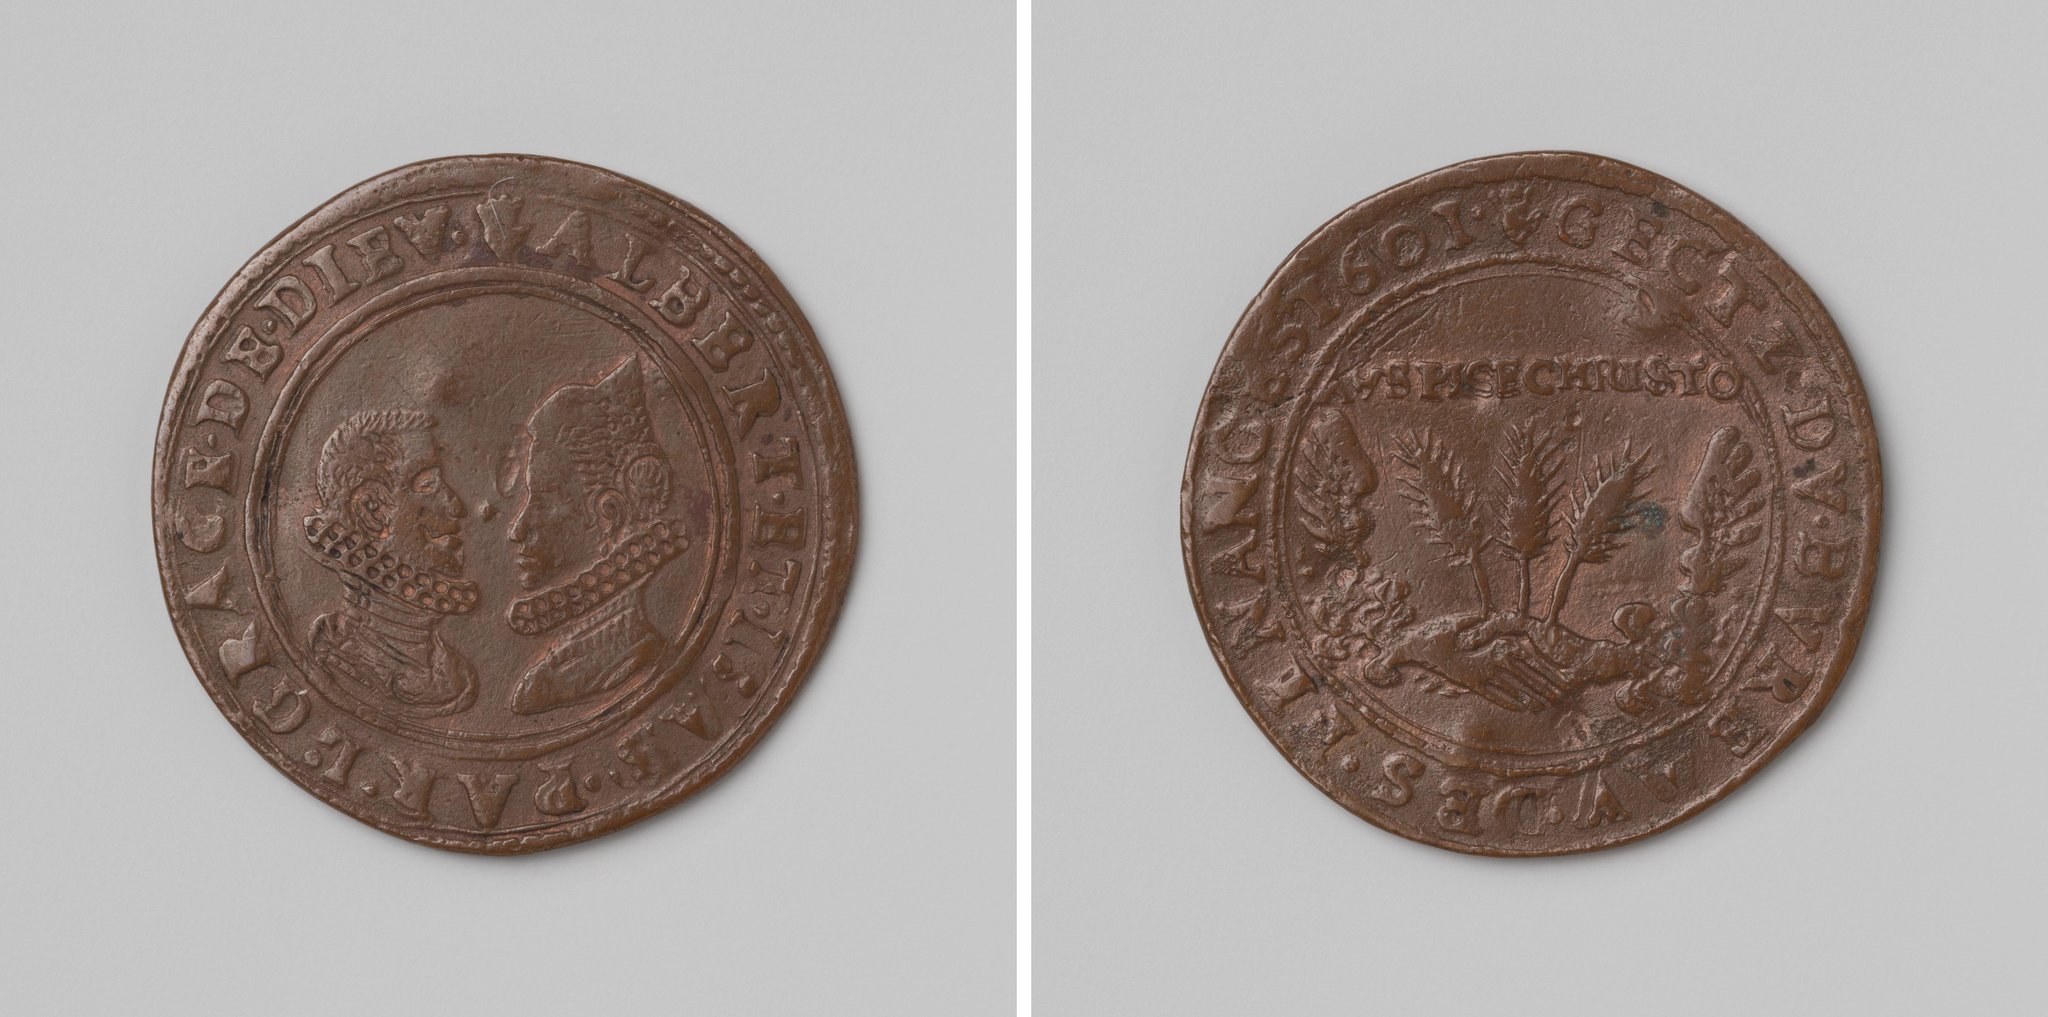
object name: jeton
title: Albrecht en Isabella van Oostenrijk, rekenpenning van de raad van Financiën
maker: Anonymous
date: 1601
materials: copper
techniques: striking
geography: antwerp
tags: infante van spanje isabella clara eugenia, brussels, albrecht aartshertog van oostenrijk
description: Koperen penning. Voorzijde: naar elkaar gewende borststukken van man en vrouw binnen omschrift. Keerzijde: twee ineen geslagen handen met vleugels houden gezamenlijk drie korenaren vast onder opschrift binnen omschrift